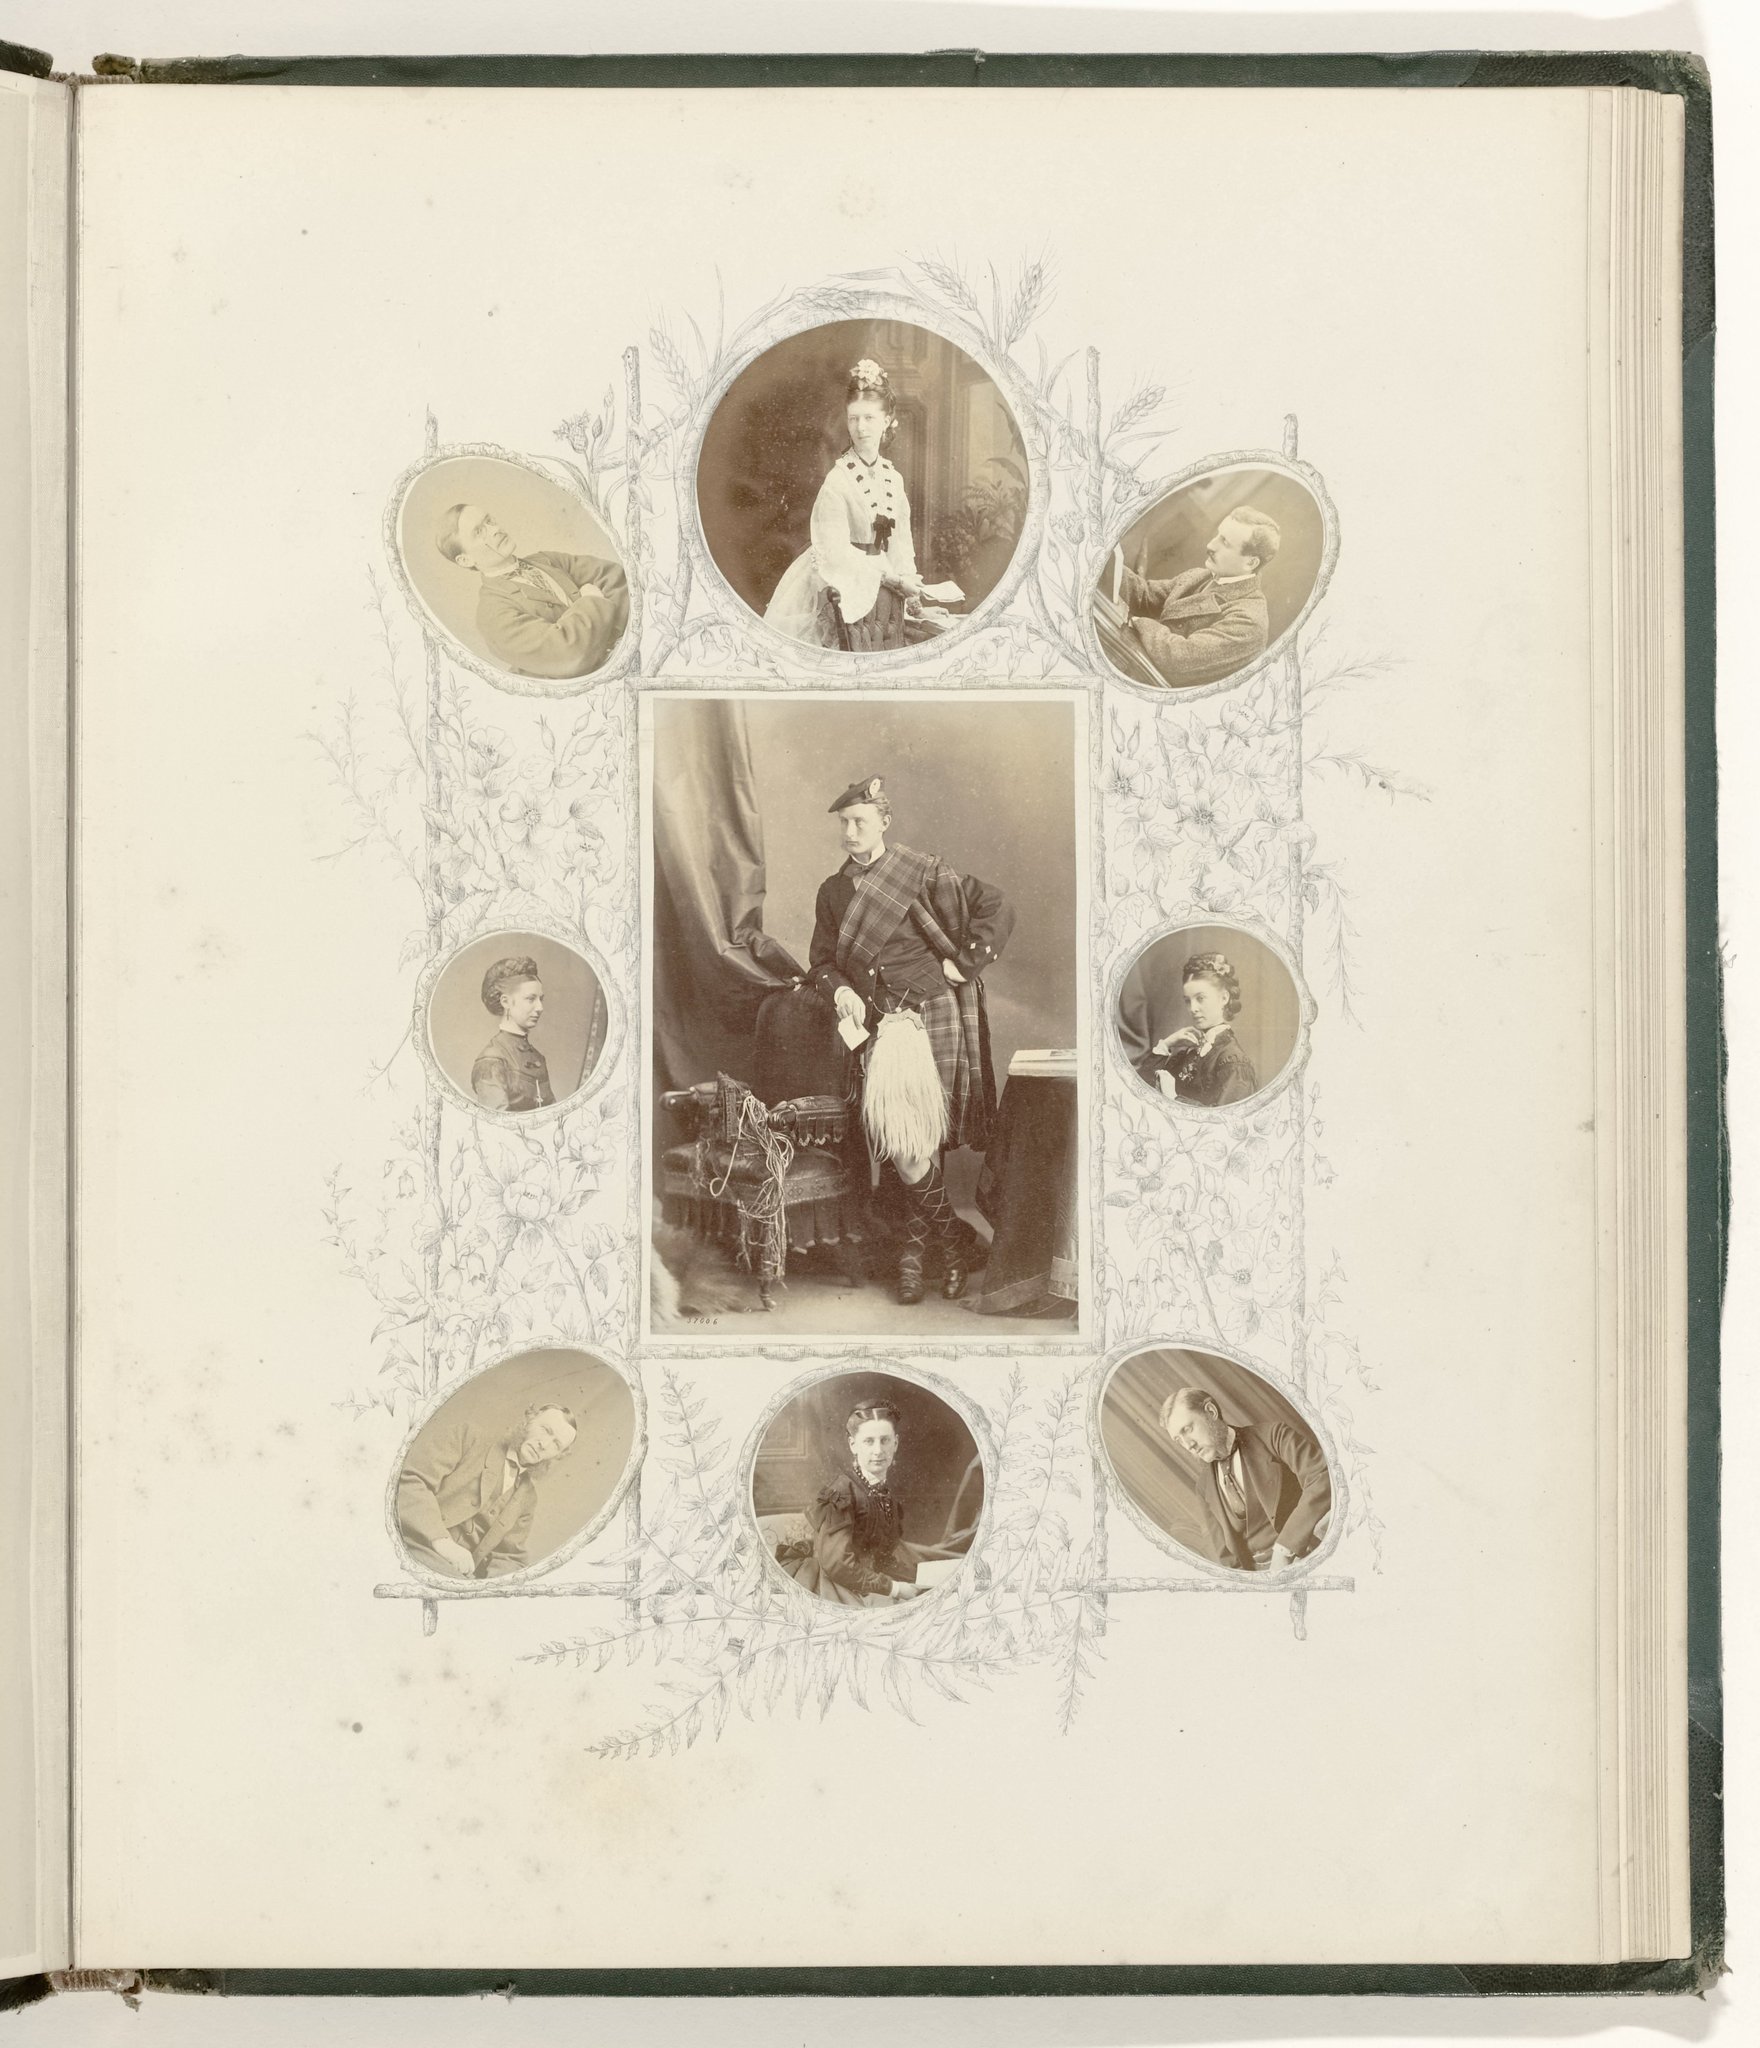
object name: photograph album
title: Fotoalbum met negentien bladen met foto's omgeven door pentekeningen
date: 1870-1890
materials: paper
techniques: albumen print, pen